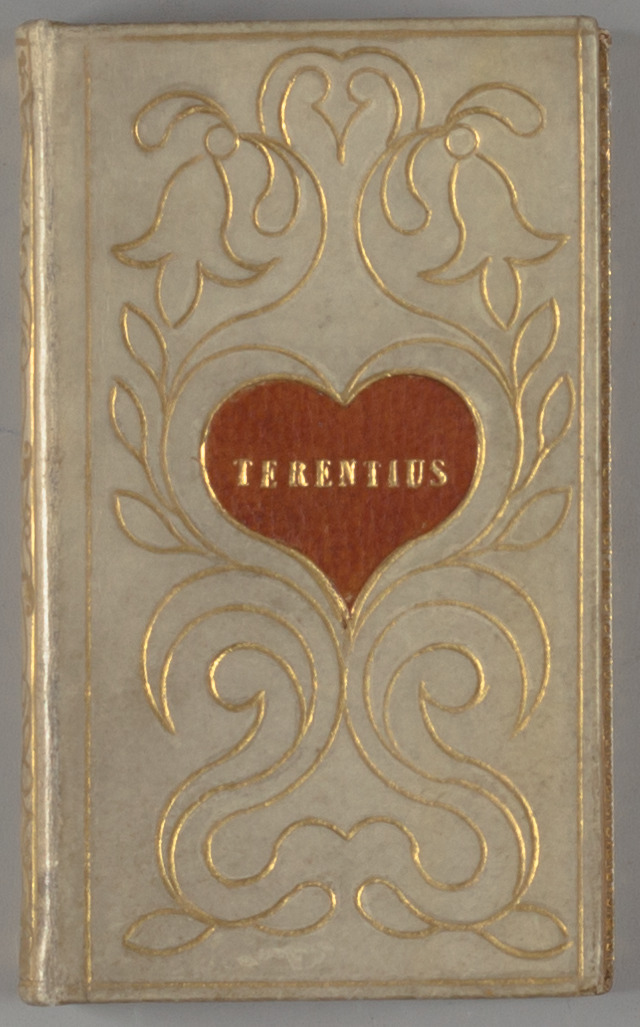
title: Publius Terentius Afer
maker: terence (publius terentius afer)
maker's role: author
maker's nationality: roman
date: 1823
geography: england